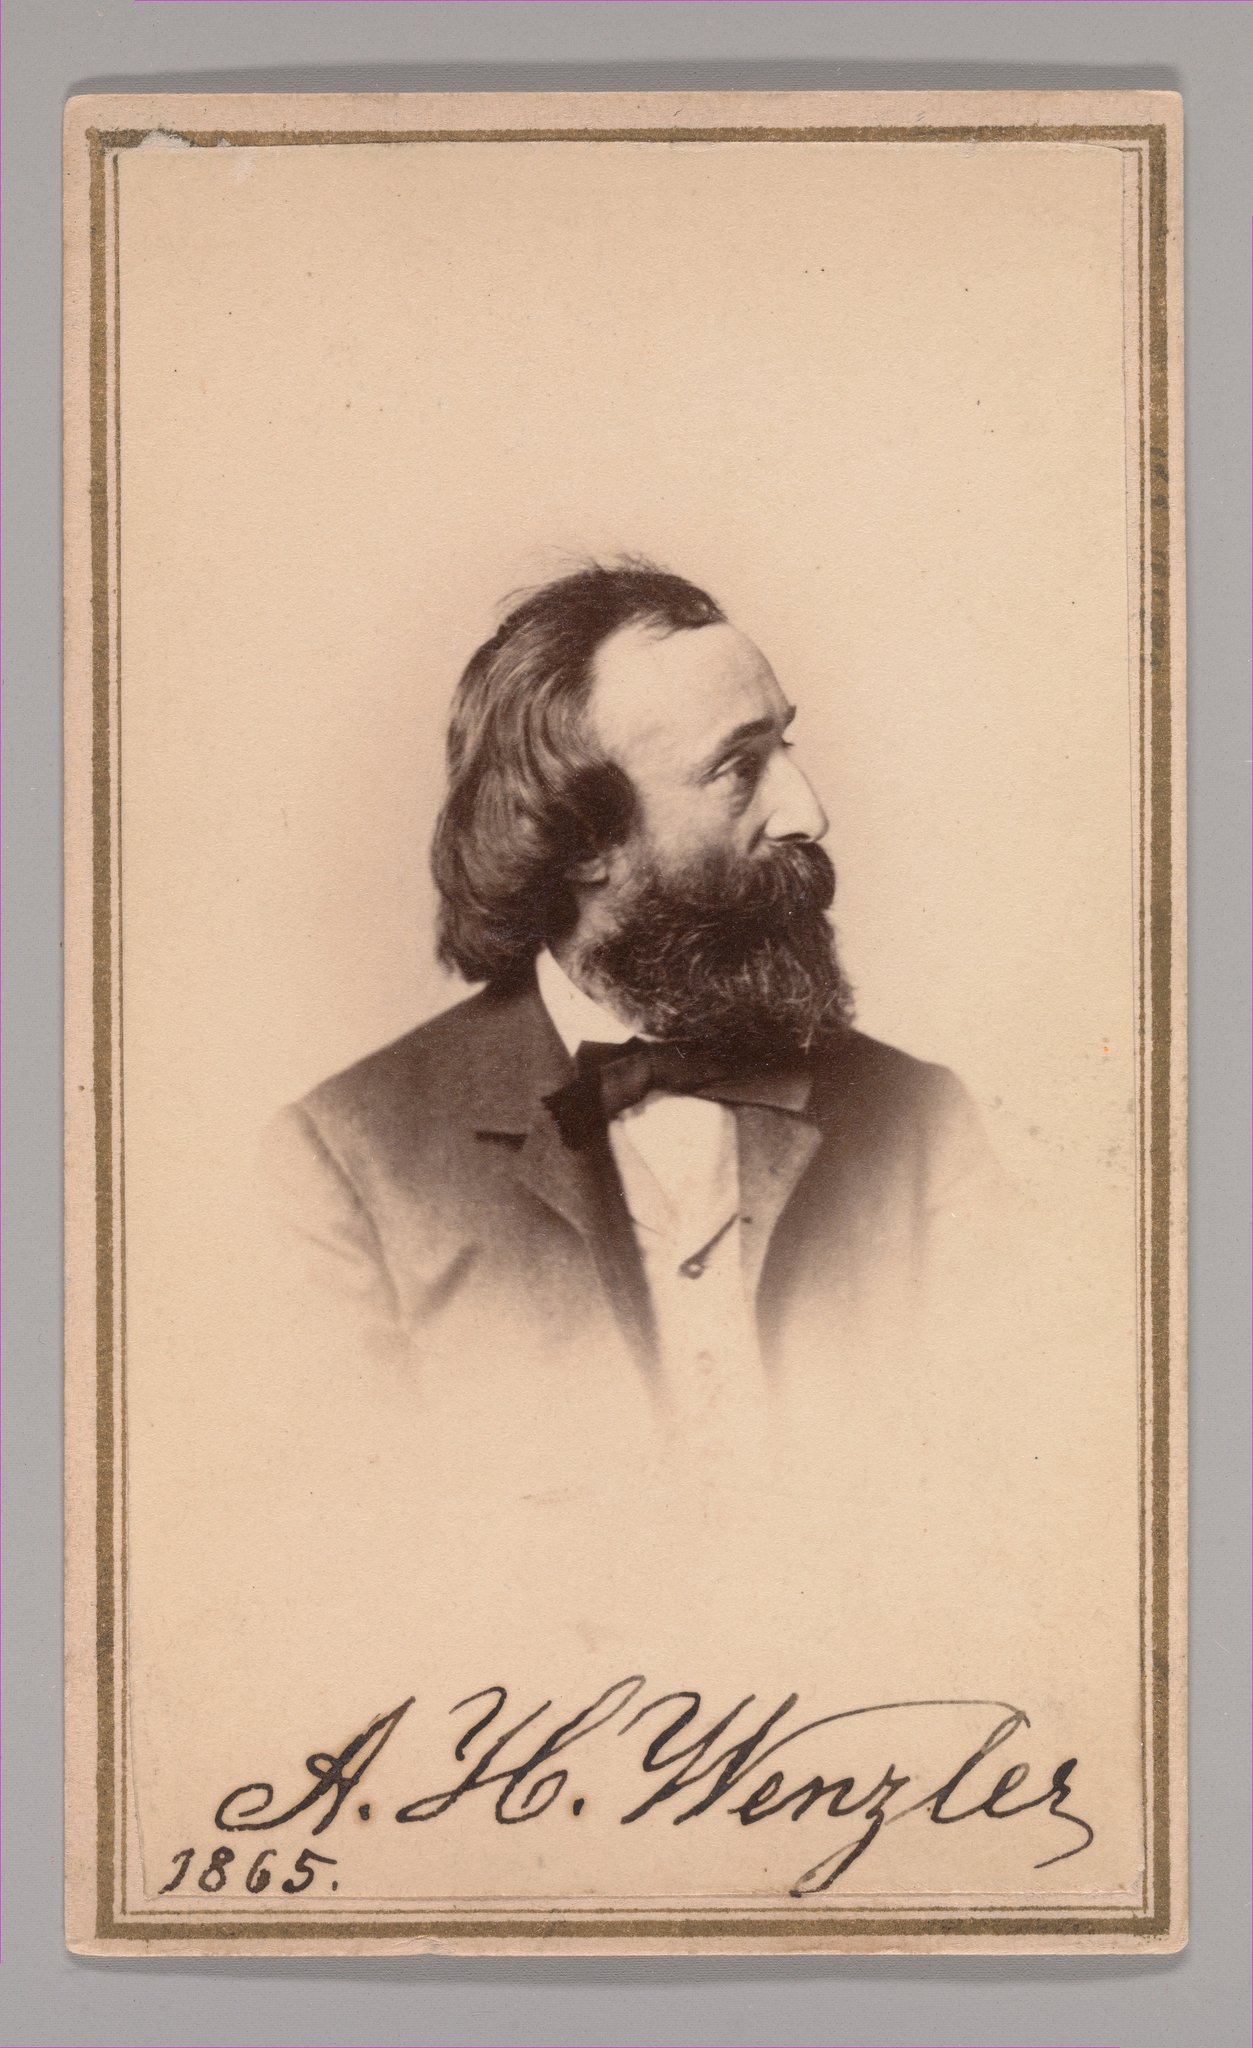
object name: carte de visite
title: [A.H. Wenzler]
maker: maurice stadtfeld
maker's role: artist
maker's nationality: american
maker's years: 1860-1869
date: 1860-1869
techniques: albumen silver print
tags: men,portraits,profiles